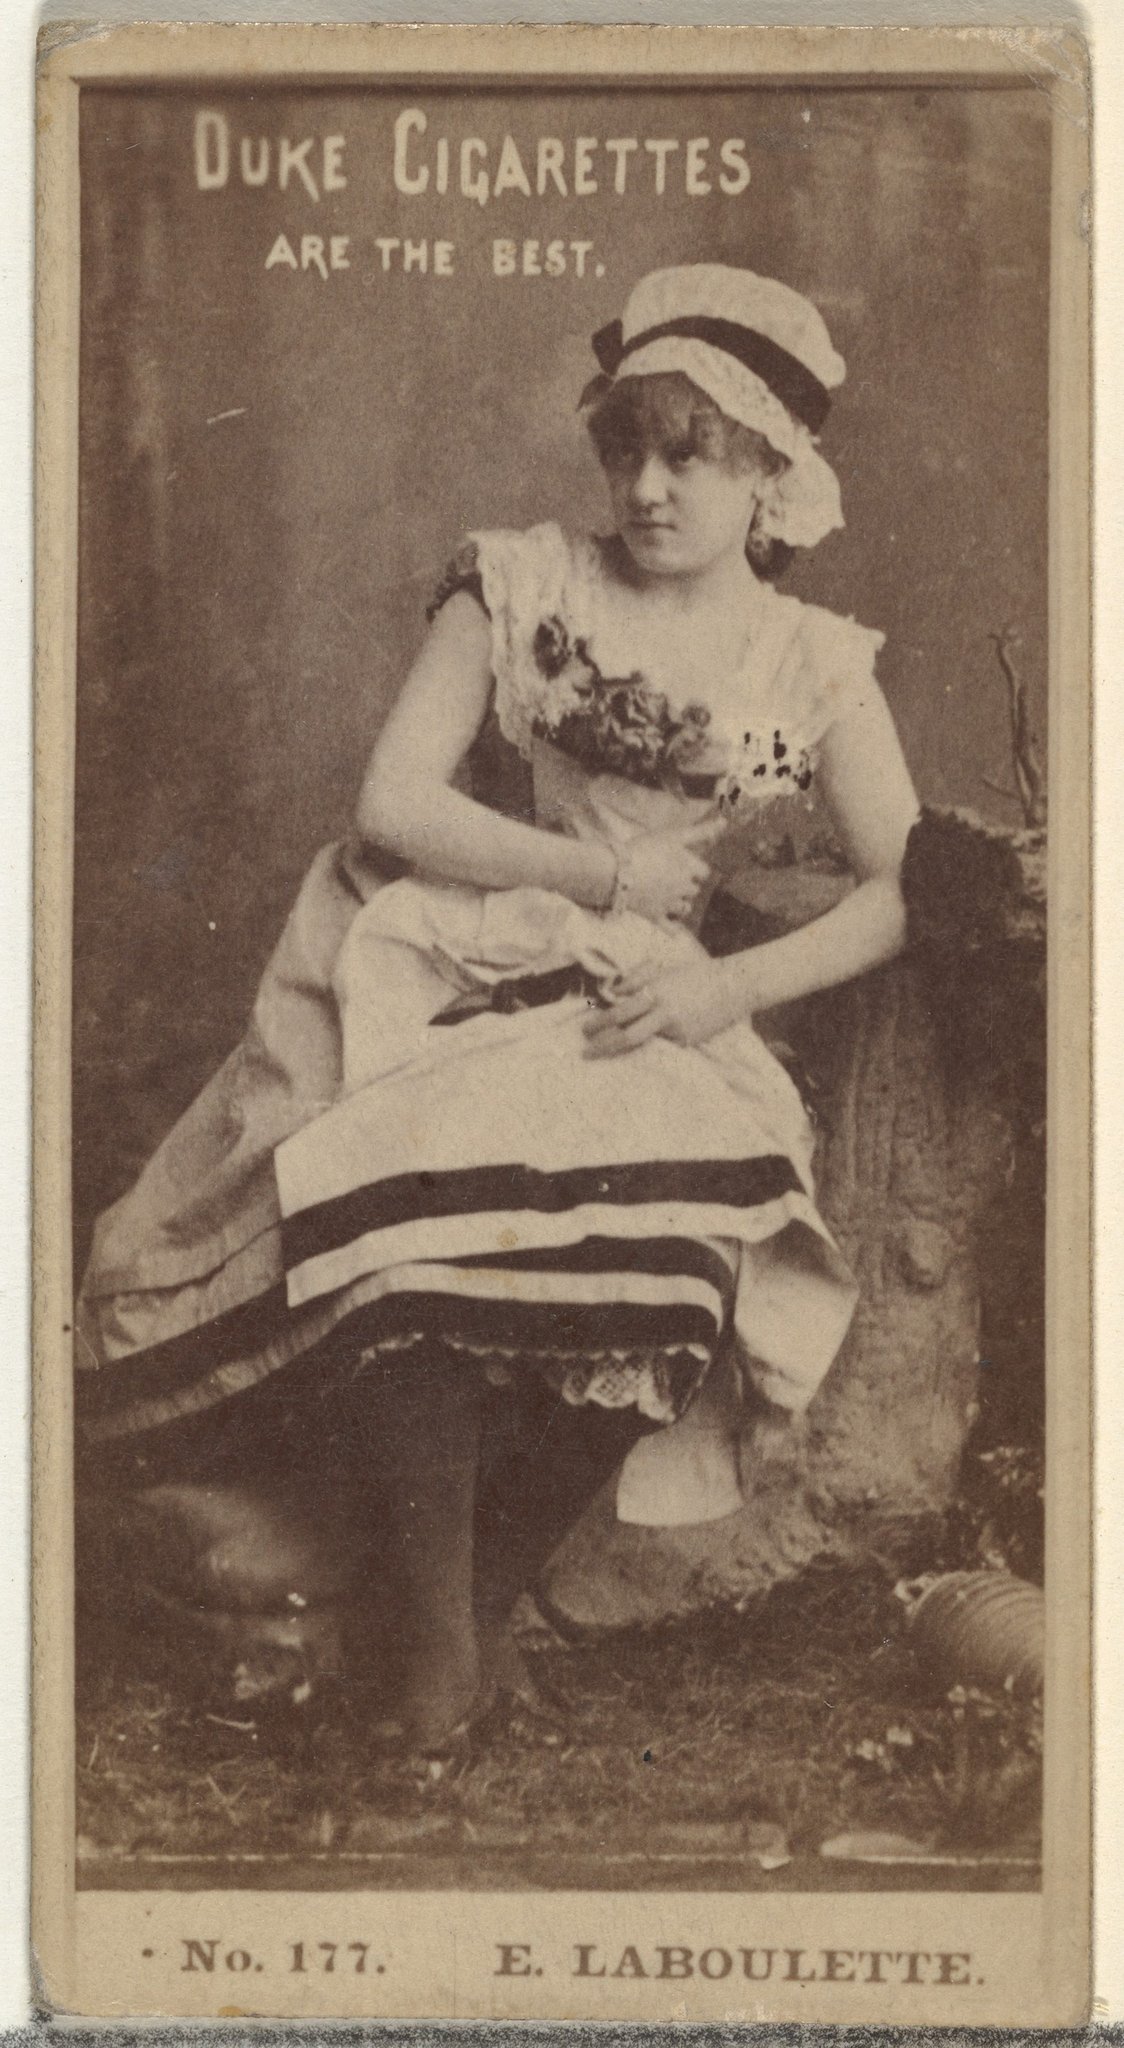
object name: photograph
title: Card Number 177, E. Laboulette, from the Actors and Actresses series (N145-6) issued by Duke Sons & Co. to promote Duke Cigarettes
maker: w. duke, sons & co.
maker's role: publisher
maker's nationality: american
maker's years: 1870-1920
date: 1880-1889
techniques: albumen silver print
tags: portraits,women,actresses